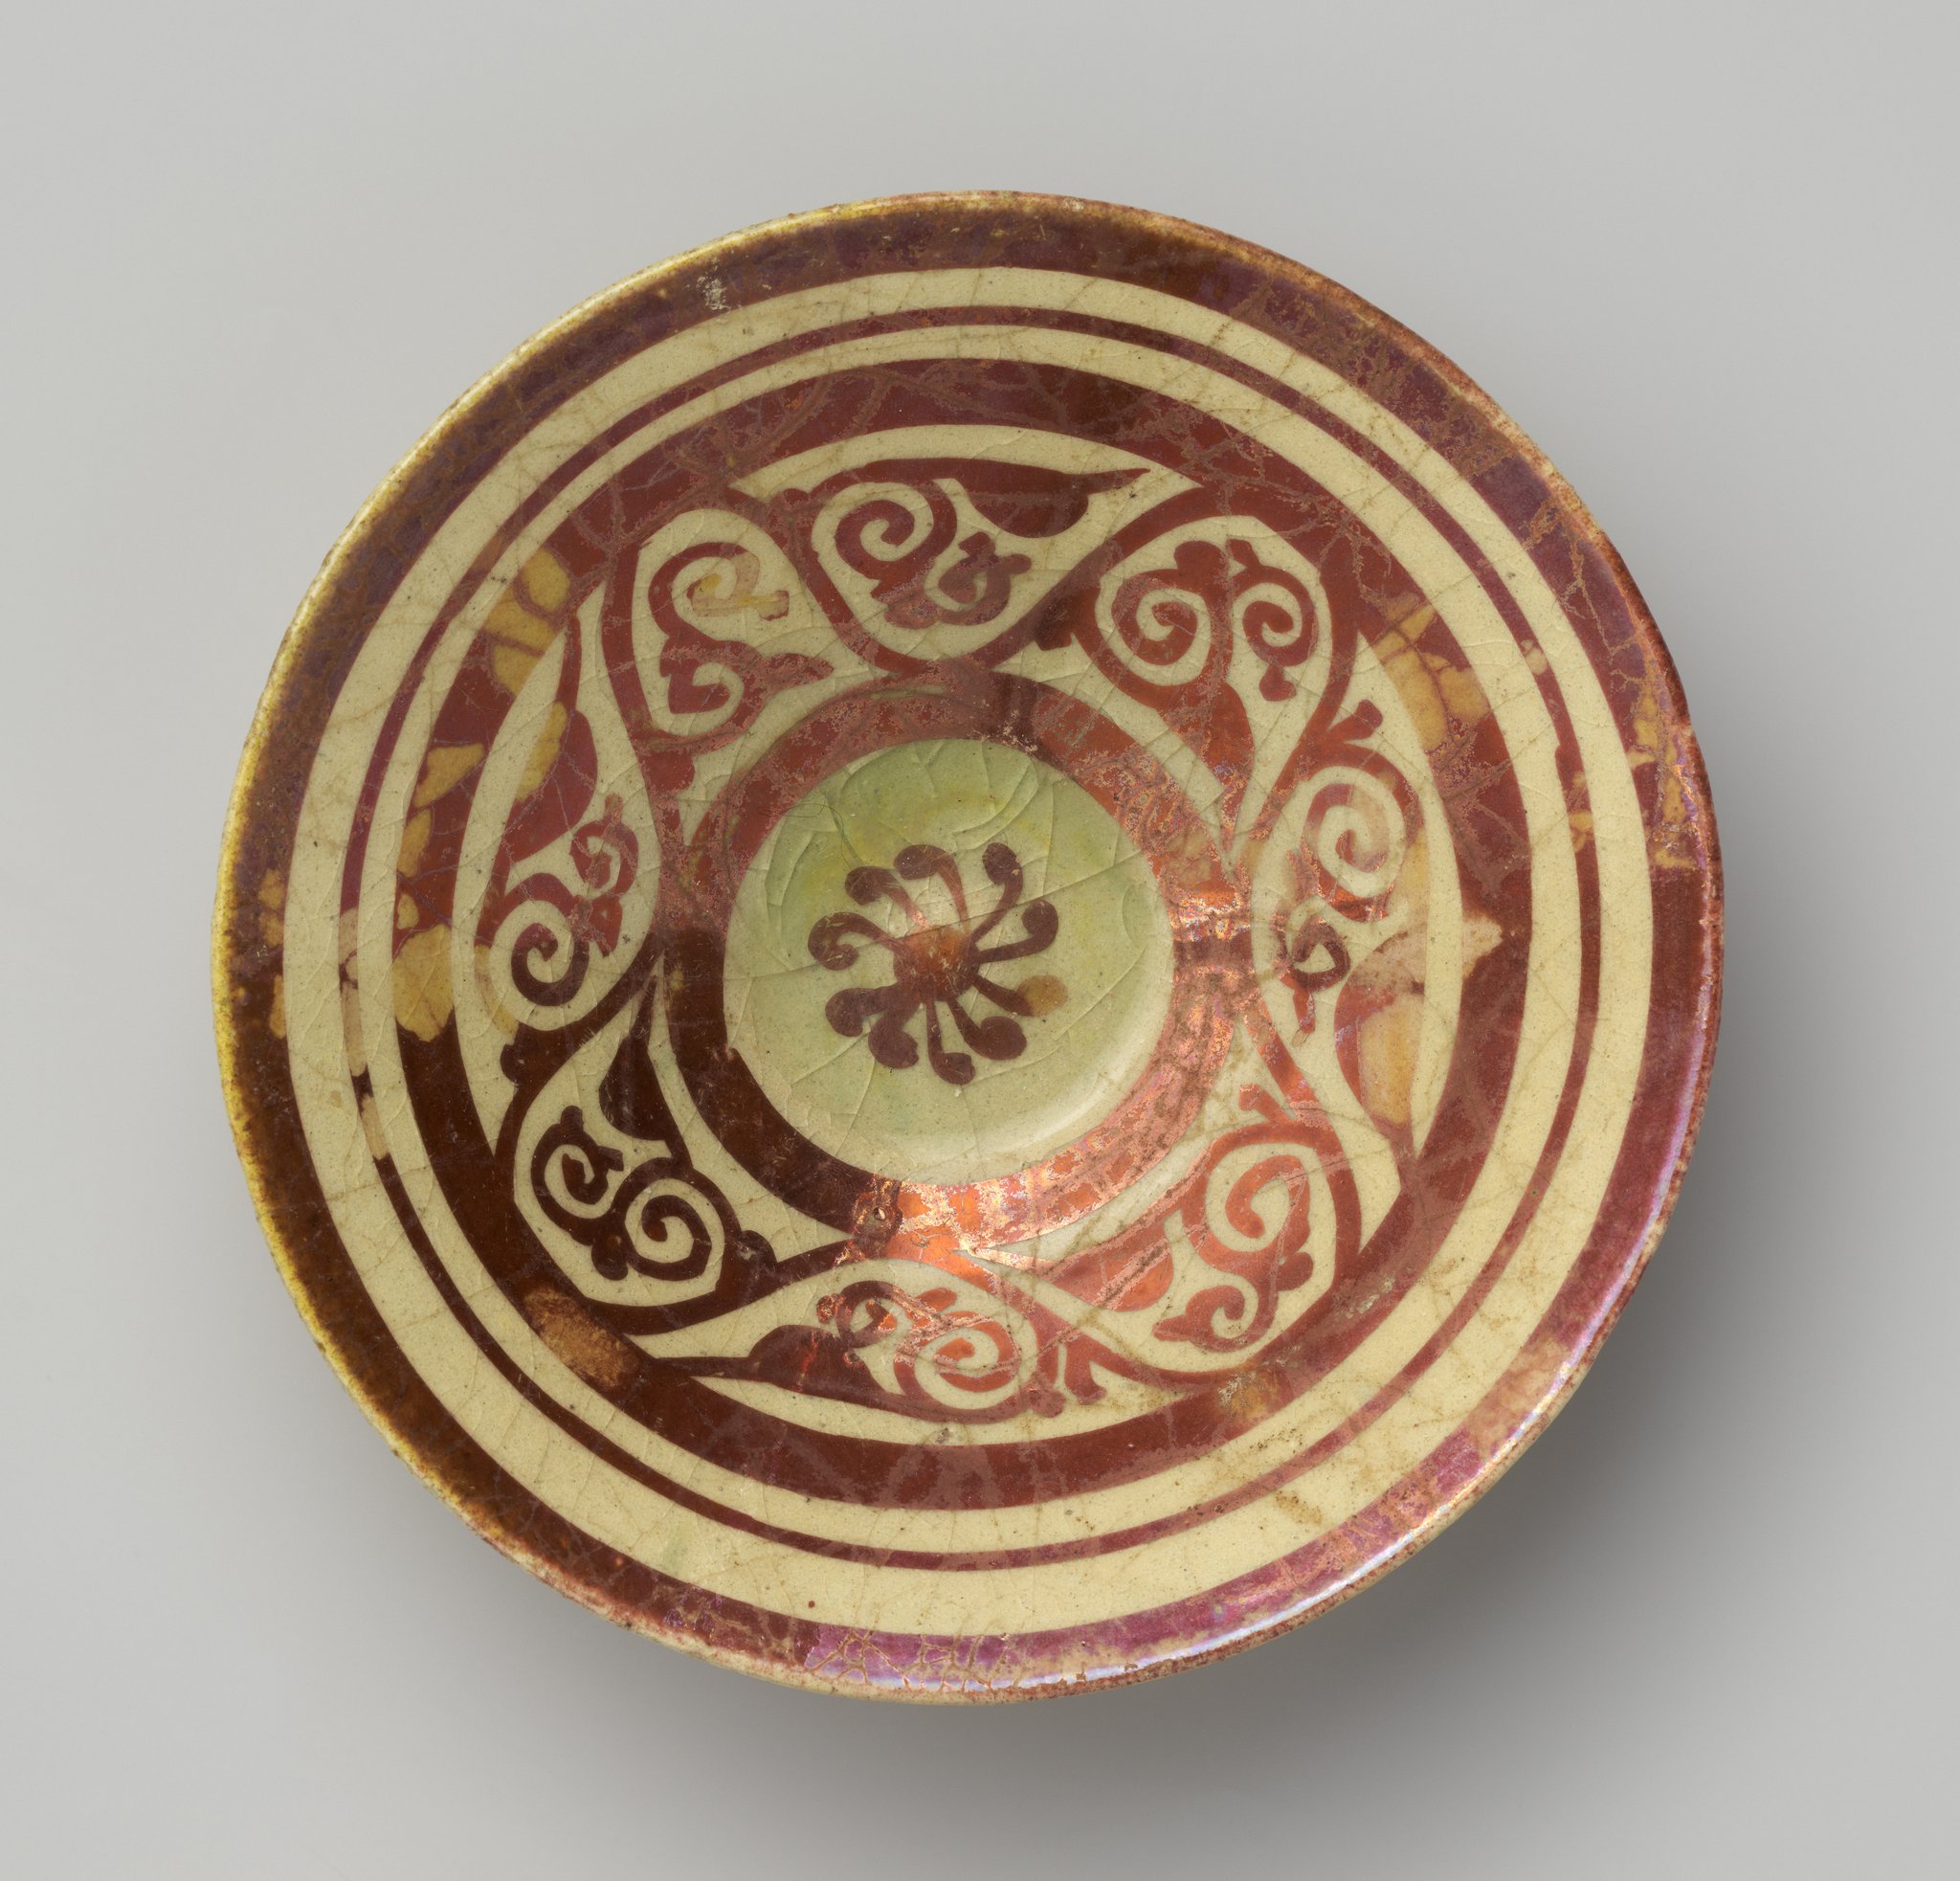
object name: bowl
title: "Tell Minis" Bowl with Vegetal Scroll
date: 1134-1166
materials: glaze, stonepaste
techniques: luster painting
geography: syria